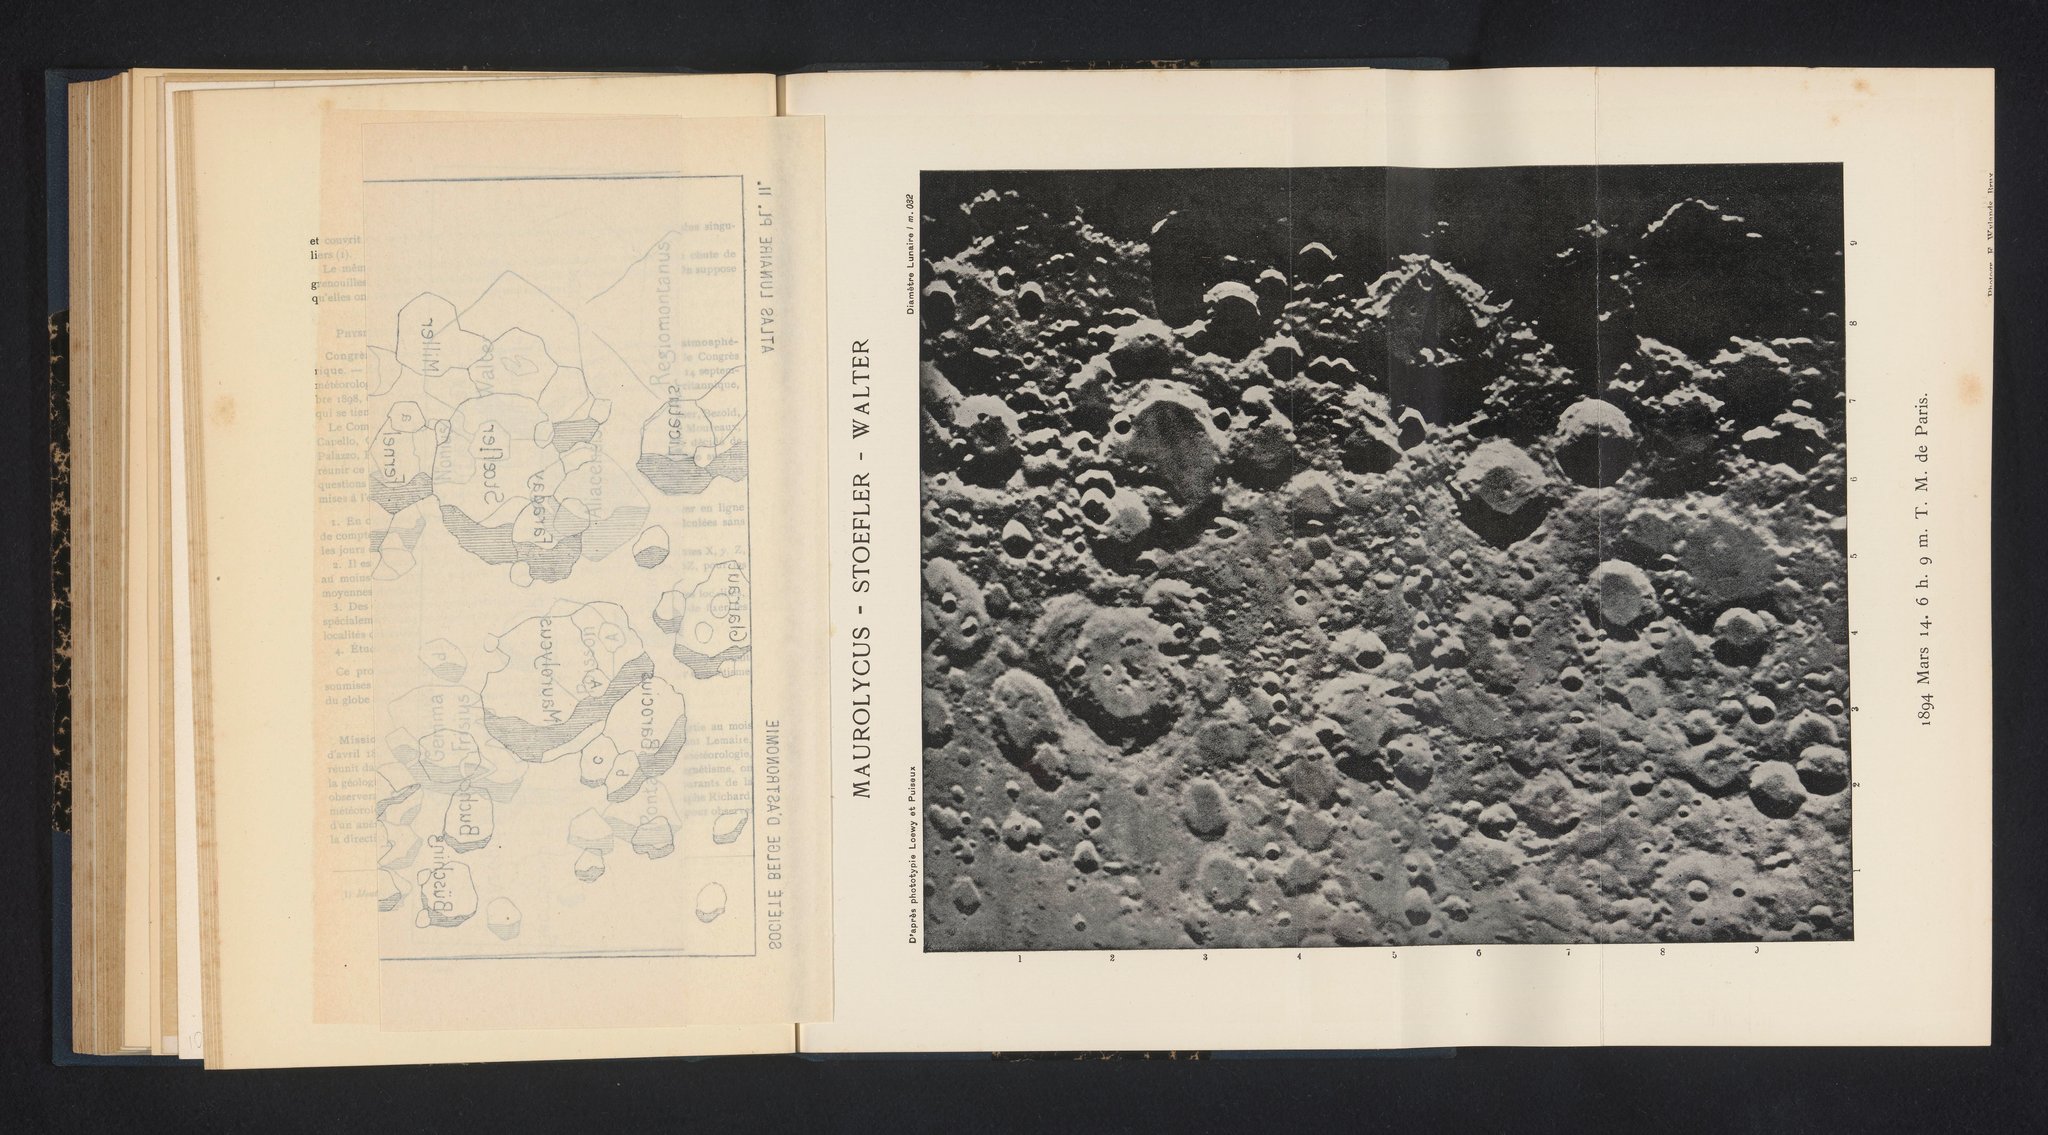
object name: photomechanical print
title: Maurolycus - Stoefler - Walter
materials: paper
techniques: autotype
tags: surface of the moon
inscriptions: inscription: ‘Société Belge d'Astronomie Atlas Lunaire Pl II/ 1894, Mars 14. 6h, 9m. (T. M. de Paris)’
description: Transparante pagina voor prent als kaart met daarop de namen van de verschillende kraters.